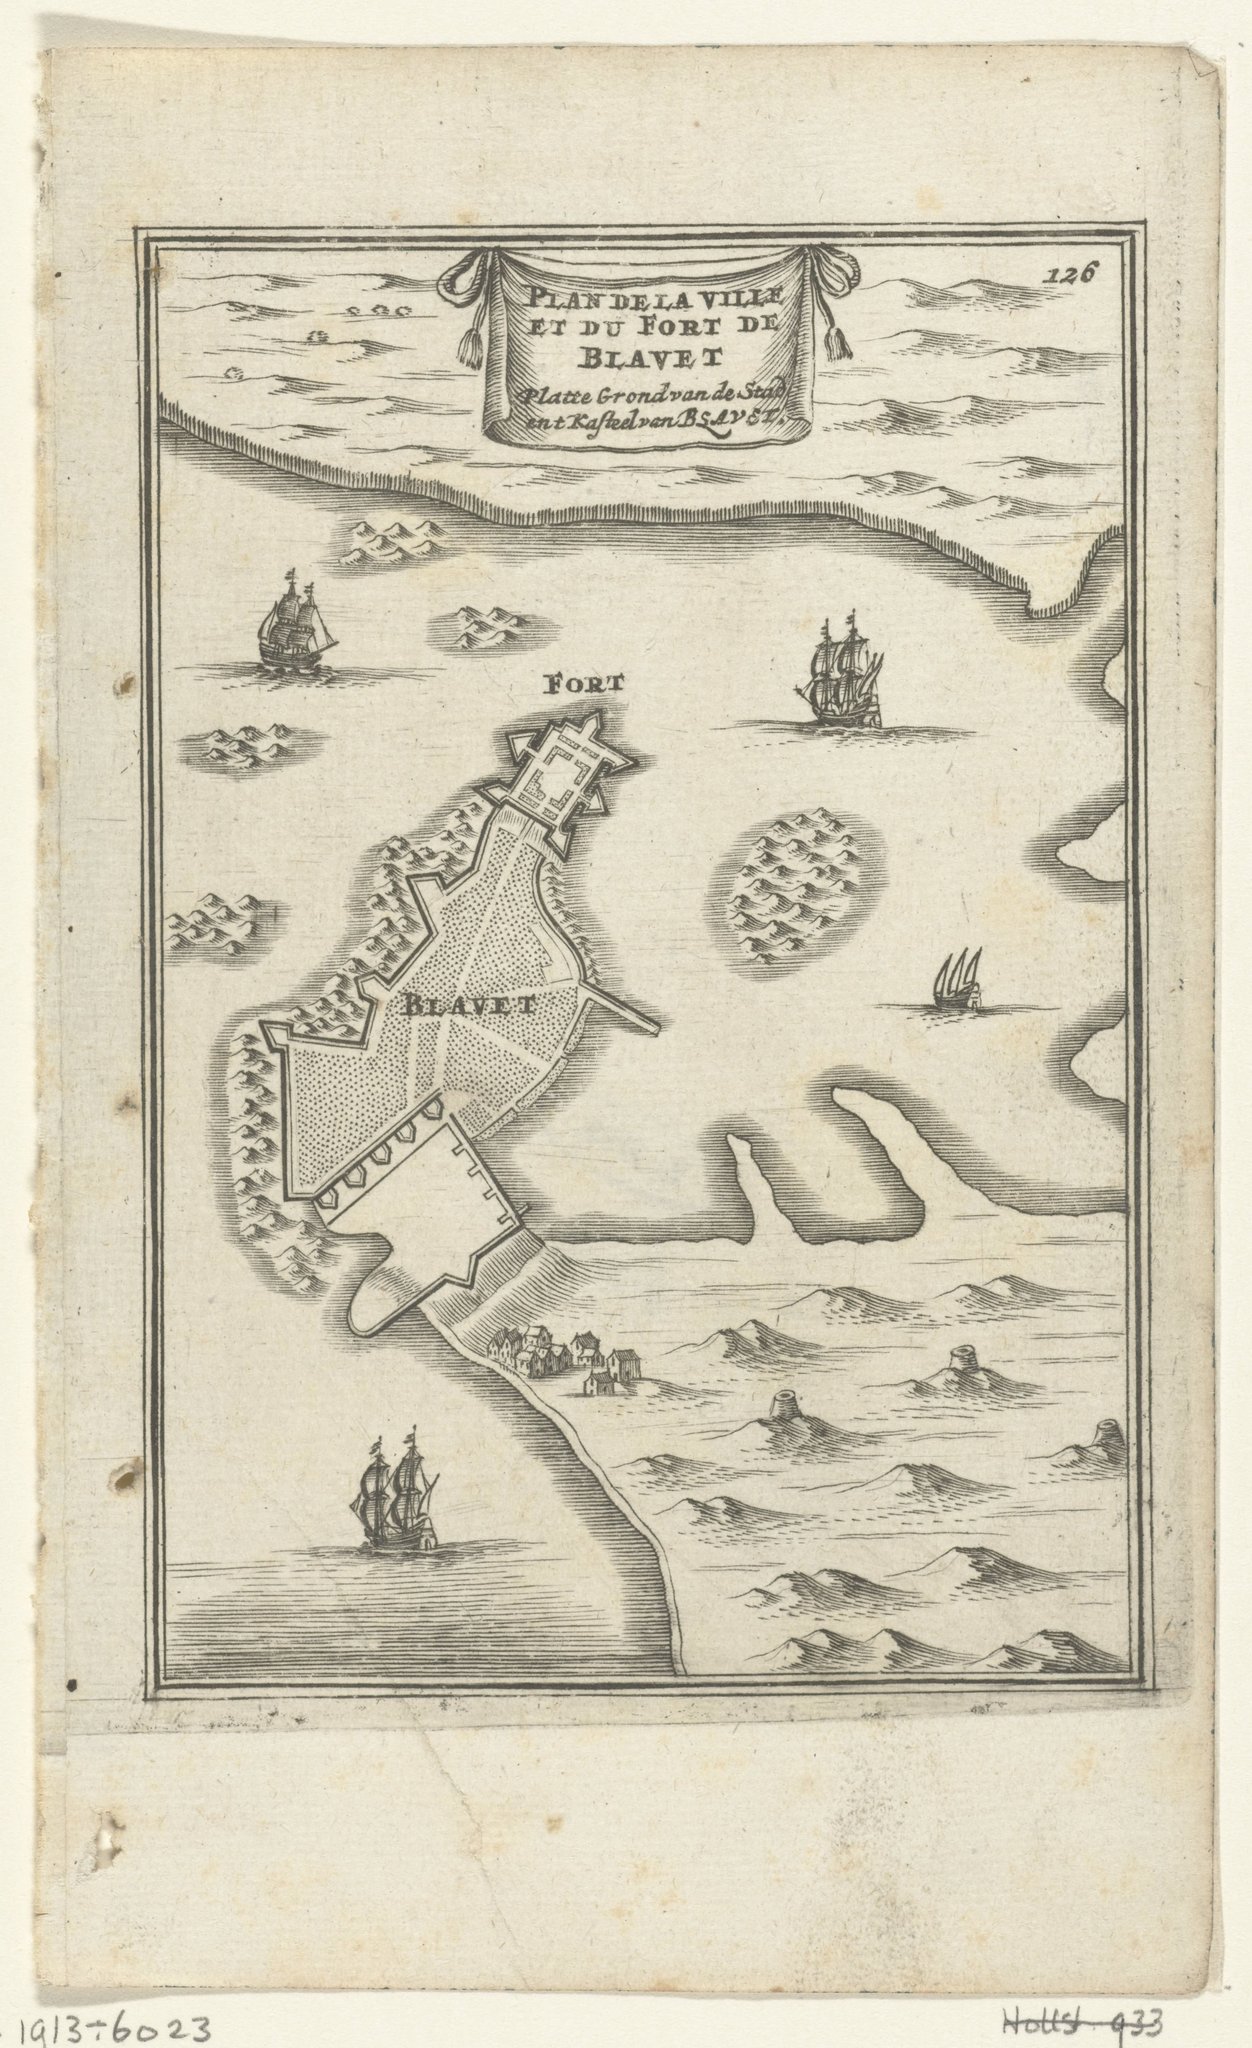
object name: print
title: Illustratie voor 'Den Arbeid van Mars' van Allain Manesson Mallet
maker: romeyn de hooghe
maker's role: draughtsman, goldsmith, painter, print maker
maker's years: 1645-1708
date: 1672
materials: paper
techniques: engraving, etching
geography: amsterdam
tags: city-view in general; 'veduta', landscapes with waters, waterscapes, seascapes (in the temperate zone), ships (in general), fortifications, military engineering, france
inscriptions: collector's mark: Lugt 2228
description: Grondplan van een vesting aan een water ('Blavet'), omringd door schepen. In de hoek rechtsboven het cijfer 126 (= het nummer van de pagina in het boek waartegenover de illustratie geplaatst is).